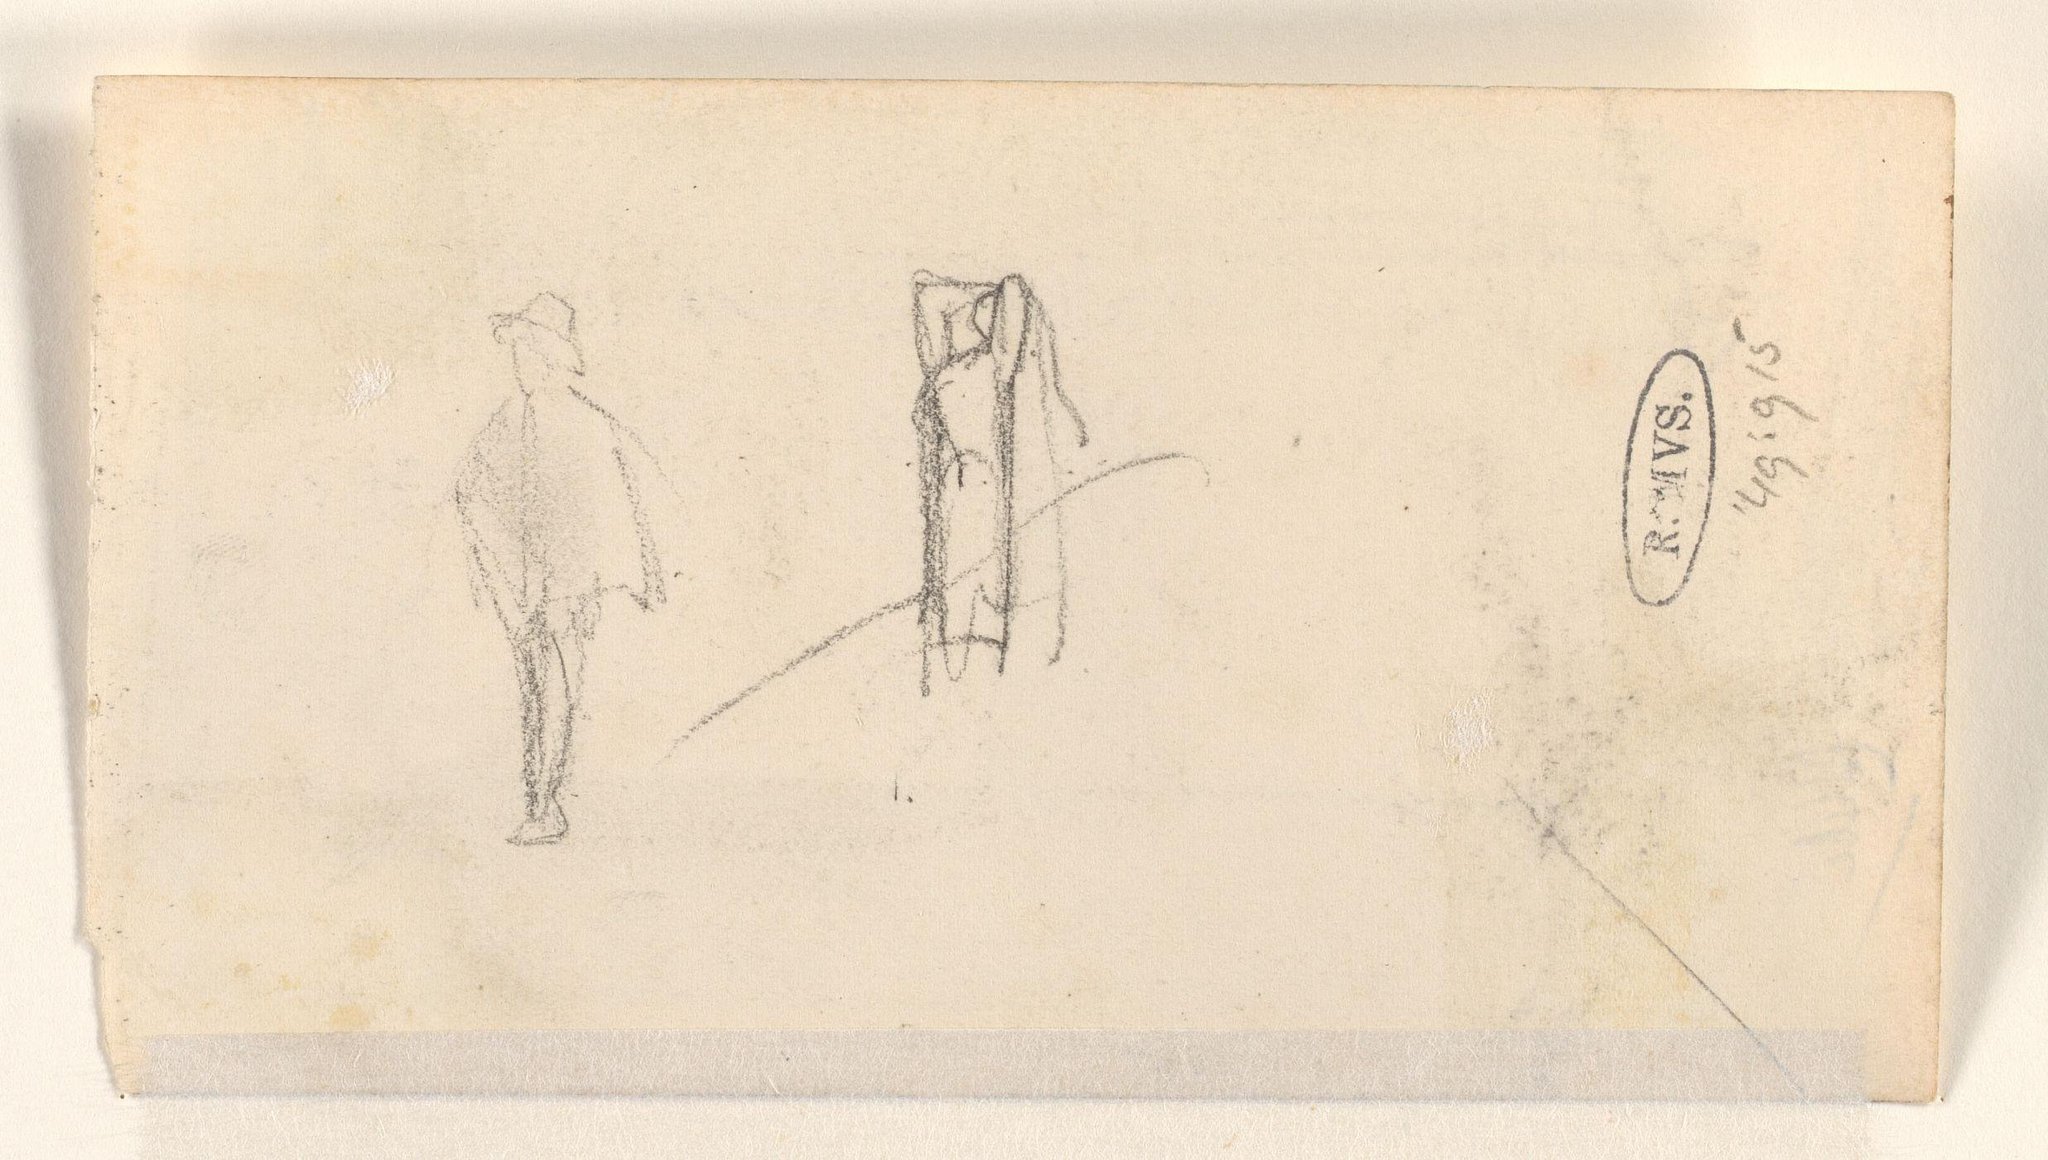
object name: drawing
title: Schetsblad met twee figuren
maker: august allebé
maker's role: draughtsman, print maker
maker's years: 1838-1927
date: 1848-1927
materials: chalk, paper